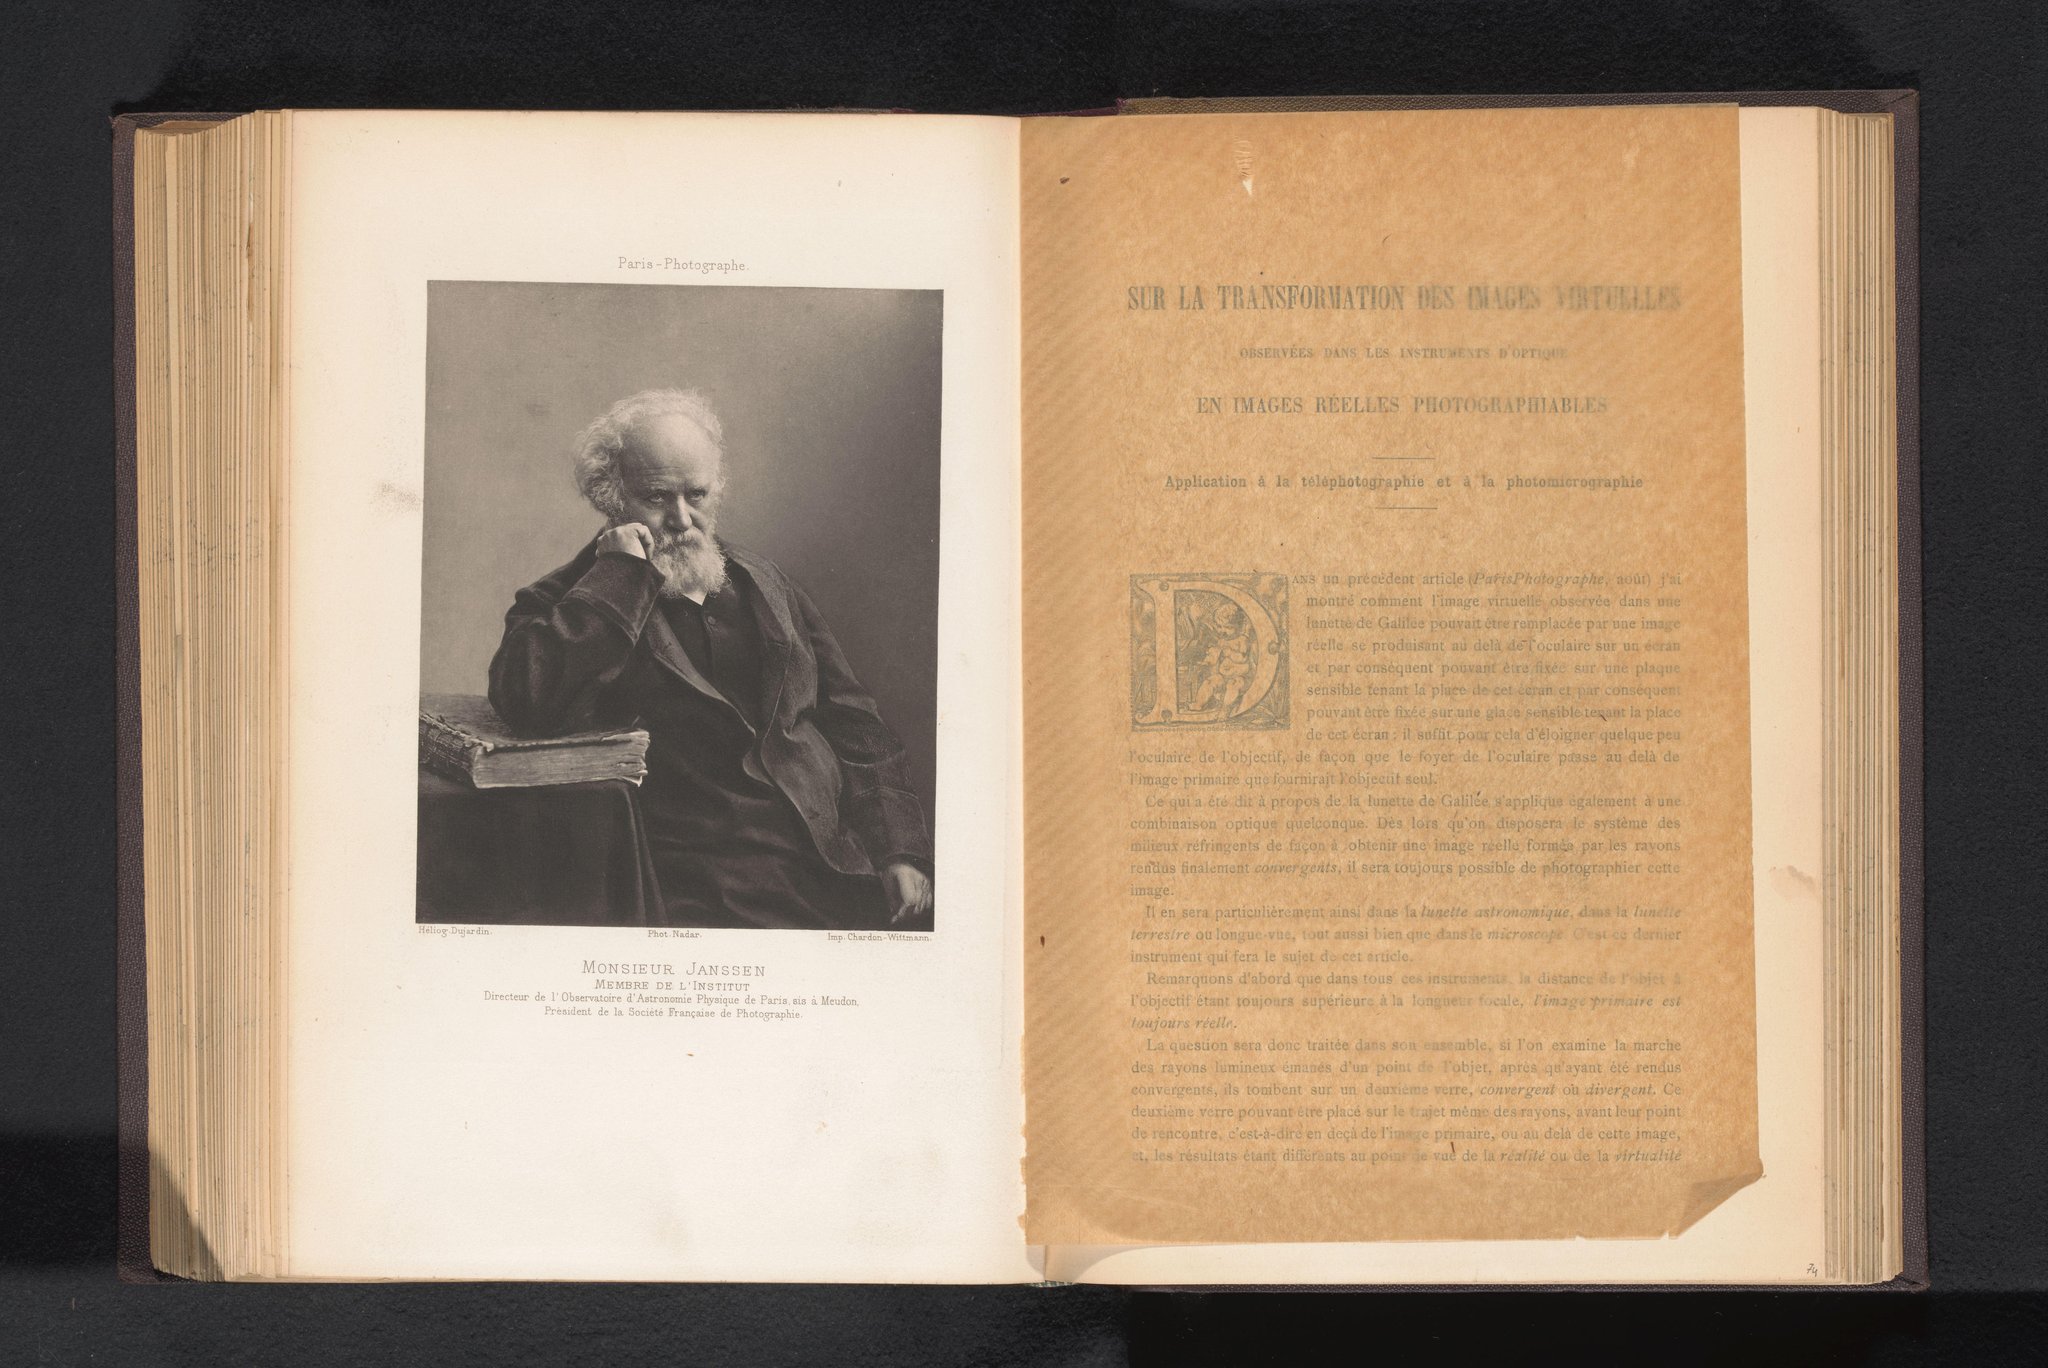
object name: page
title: Portret van Pierre Janssen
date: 1882-1892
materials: paper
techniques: photoaquatint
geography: paris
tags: paris, pierre jules césar janssen, astronomy (and cosmography)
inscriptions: inscription: ‘Membre de l'Institut Directeur de l'Observatoire d'Astronomie Physique de Paris sis à Meudon, Prèsident de la Sociéte' Française de Photographie.’